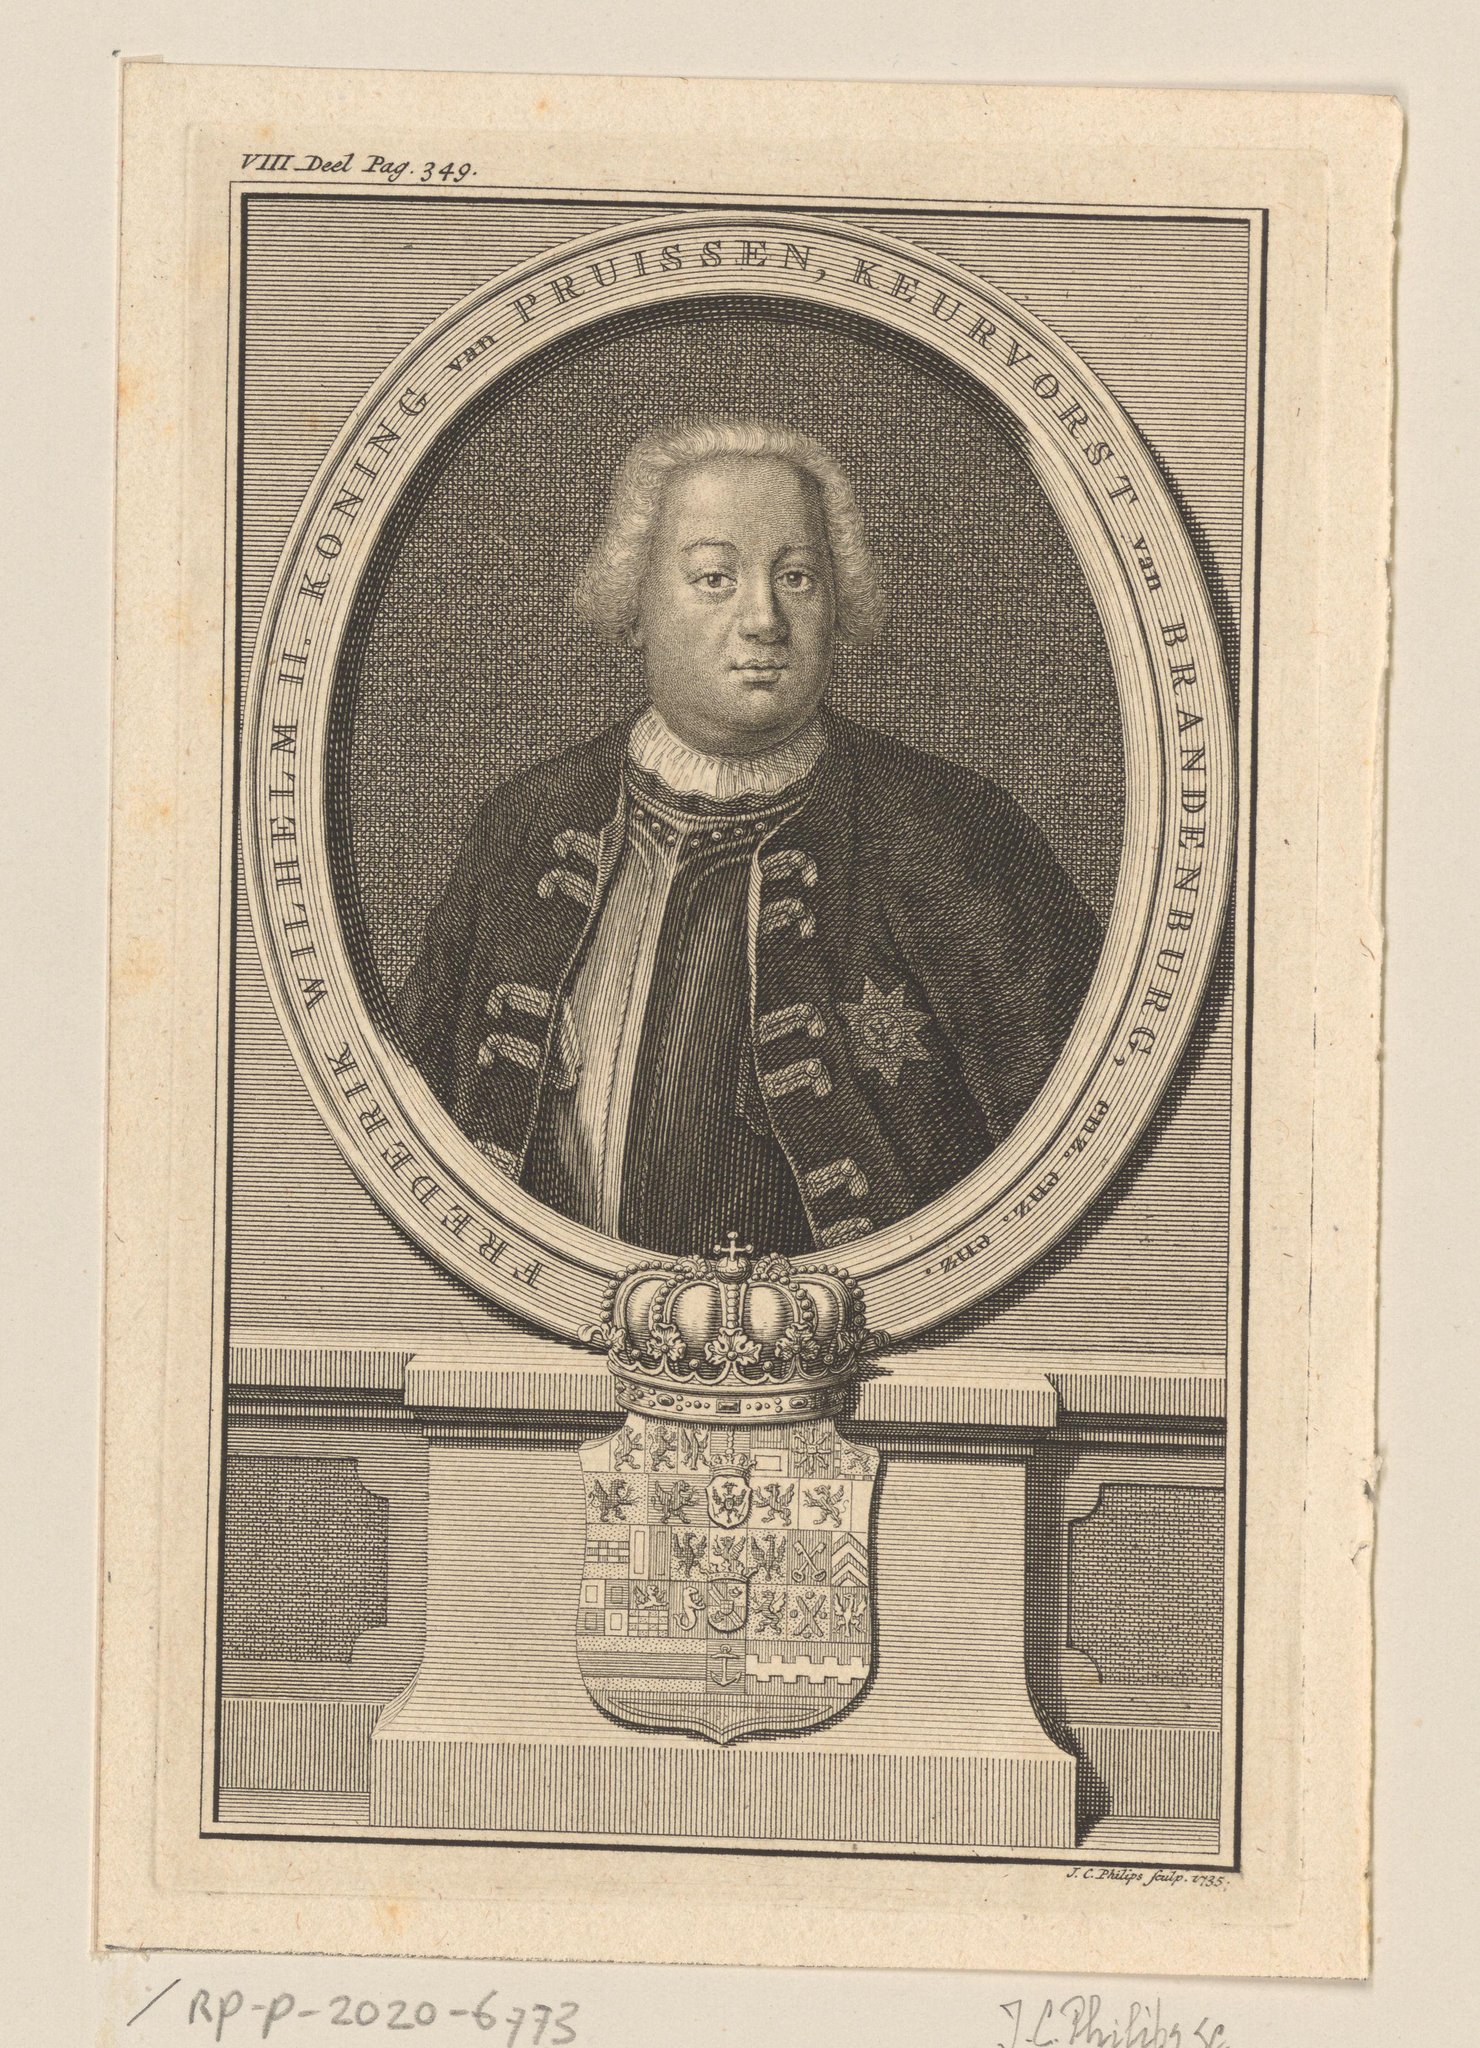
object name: print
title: Frederik Wilhelm II. Koning van Pruissen (...)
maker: jan caspar philips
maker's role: draughtsman, print maker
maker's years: 1700-1775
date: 1735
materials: paper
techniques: etching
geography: amsterdam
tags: berlin, coat of arms (symbol of sovereignty), ornament ~ medallion, historical persons, king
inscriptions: date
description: Op het portret staat de foutieve titel 'Frederik Wilhelm II'. Prent waarschijnlijk uit: Salmon, Thomas. Hedendaagsche historie, of Tegenwoordige staat van alle volkeren (...). Amsterdam: Isaak Tirion, 1736, dl. 8, p. 349.